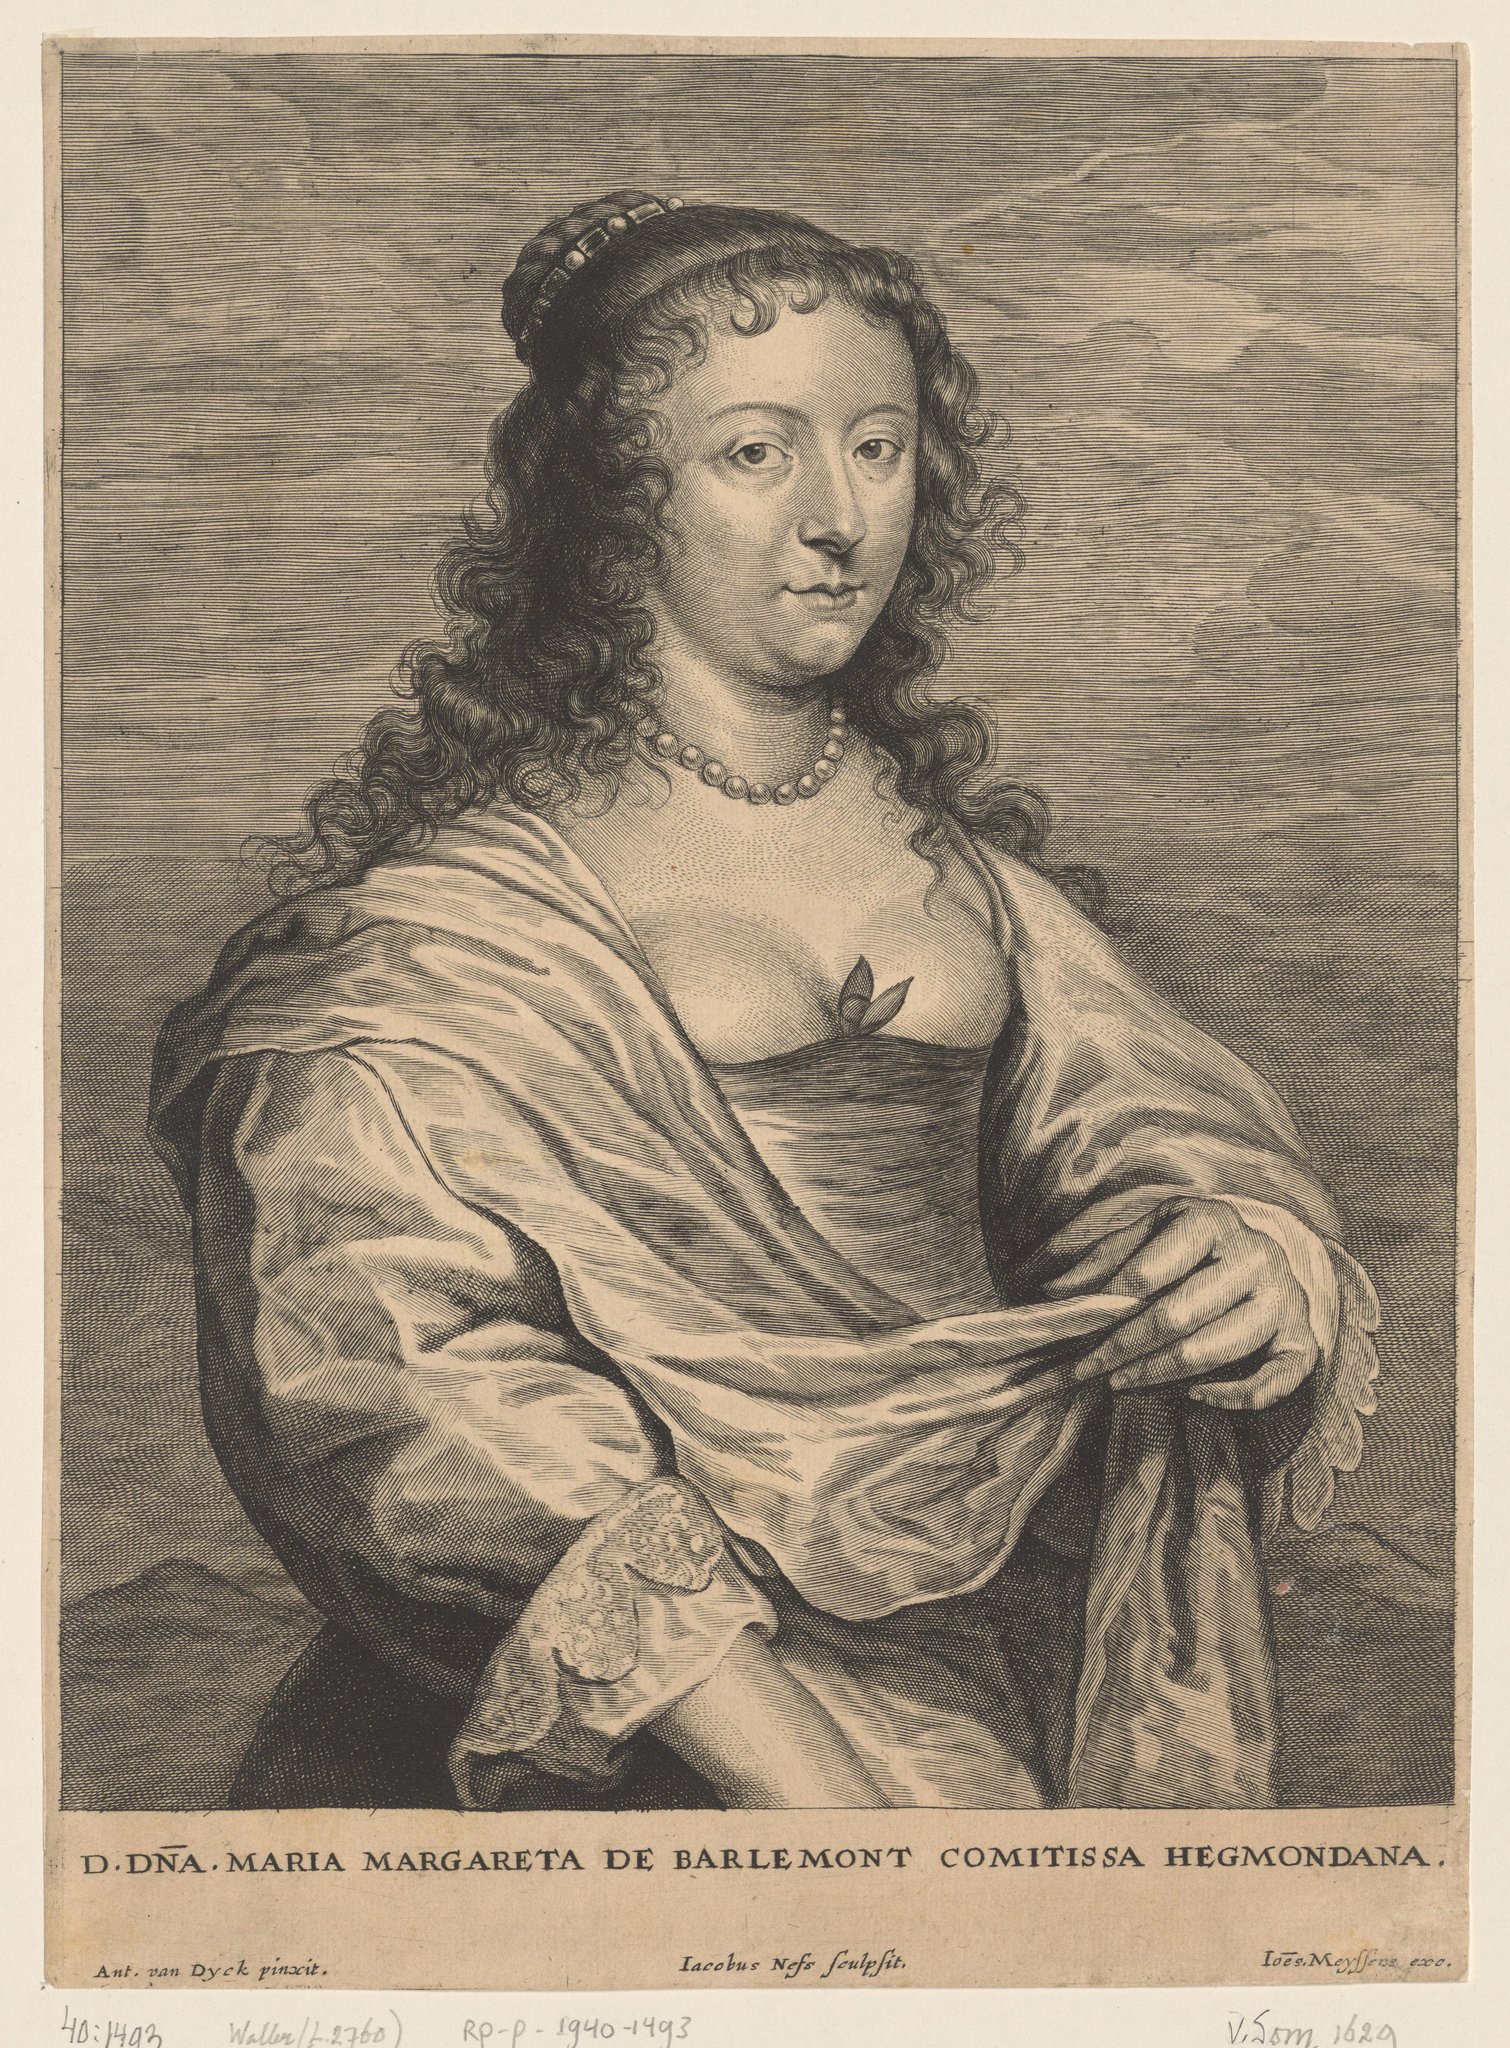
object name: print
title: Portret van Maria Margaretha de Berlaymont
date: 1640-1670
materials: paper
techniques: engraving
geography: antwerp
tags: brussels, historical persons - bb - woman, pearl; pearl necklace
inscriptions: collector's mark: Lugt 2760, collector's mark: Lugt 2166